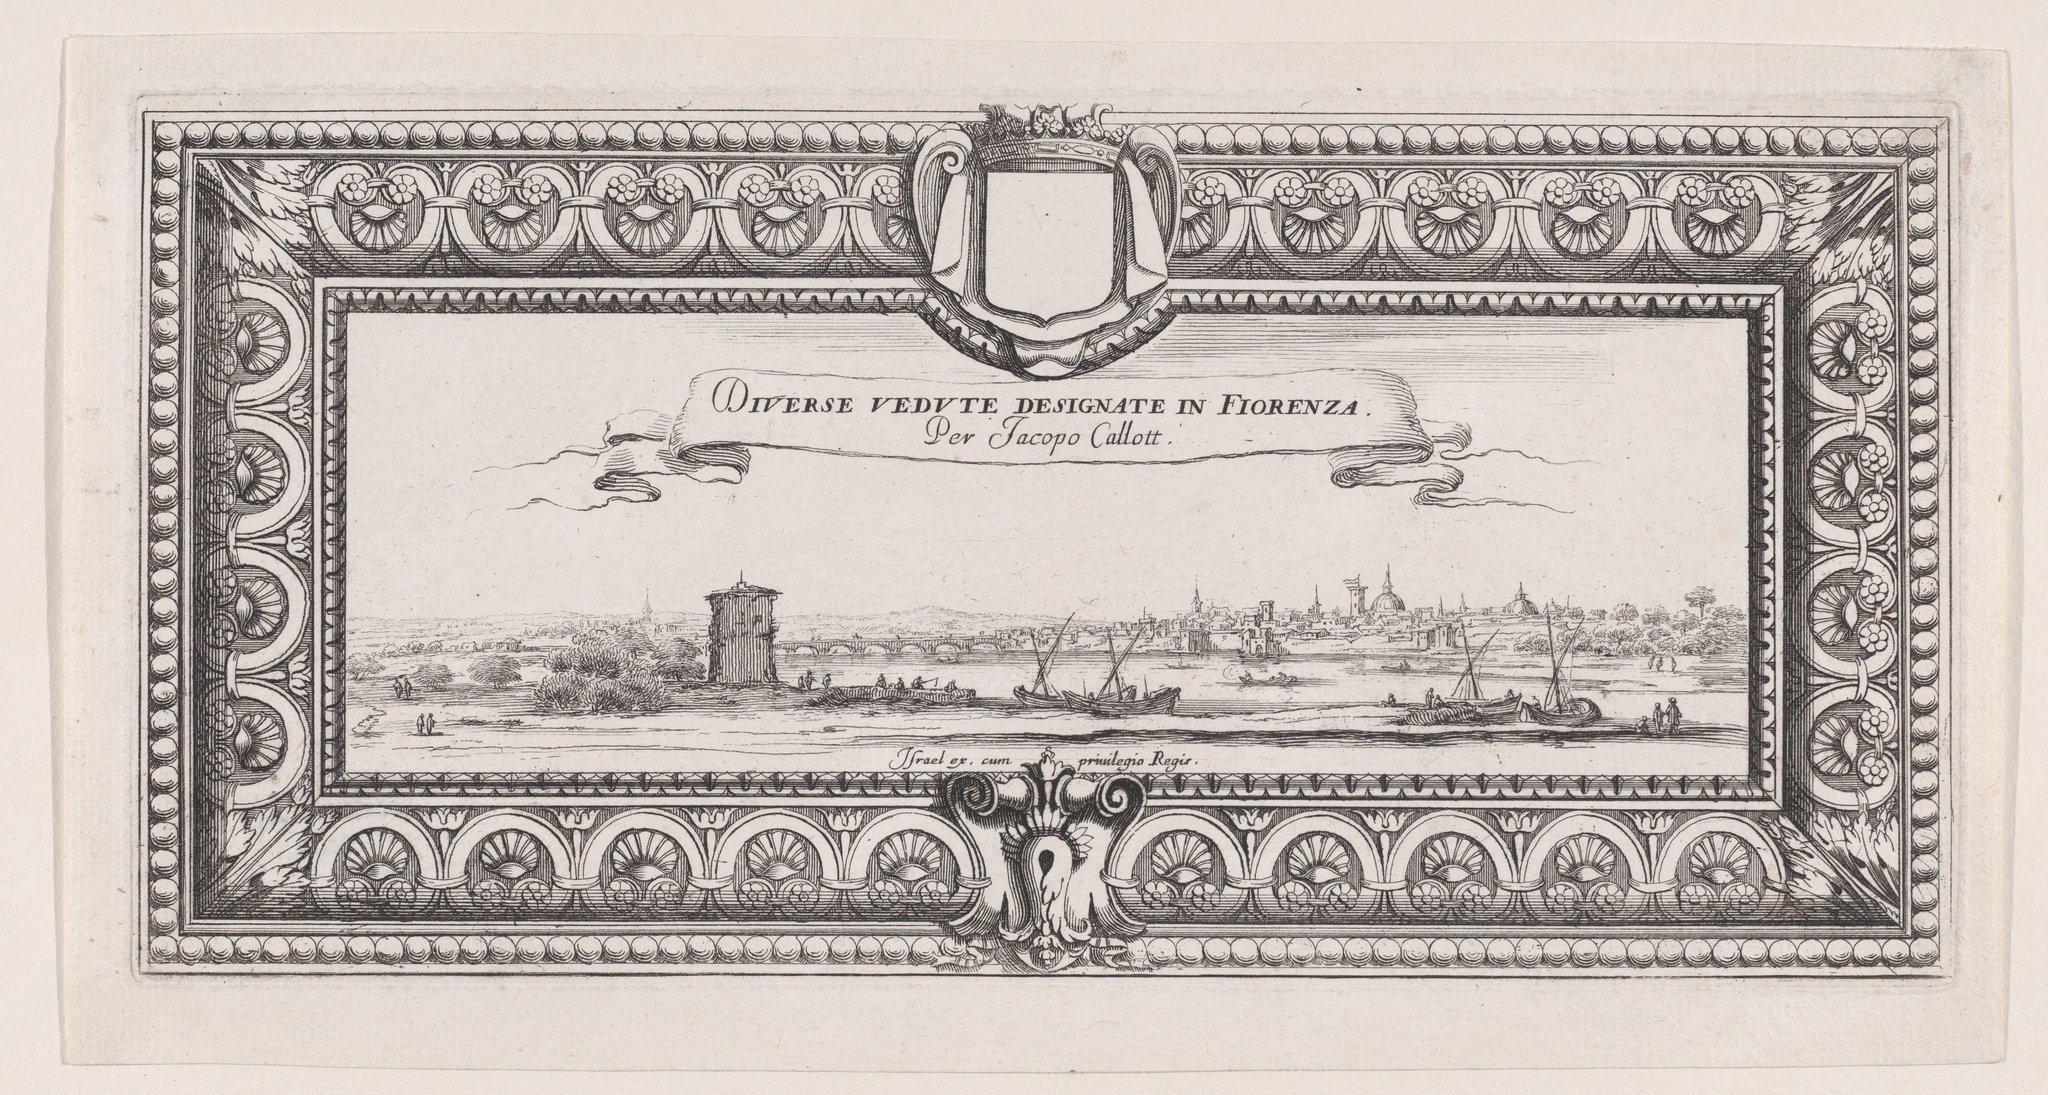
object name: print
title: Title Page Designed for the Sale of the Series of Paysages Gravés pour Jean de Médicis, from "Paysages Gravés pour Jean de Médicis appelées aussi Paysages Dessinés a Florence, Vues de Florence, Paysages d'Italie, et Paysages Définitifs" (Landscapes Engraved for Giovanni de'Medici, Landscapes Designed in Florence, Views of Florence, Landscapes of Italy, and Definitive Landscapes)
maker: françois collignon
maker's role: artist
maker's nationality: french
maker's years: 1605-1687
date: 1618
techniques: engraving, etching